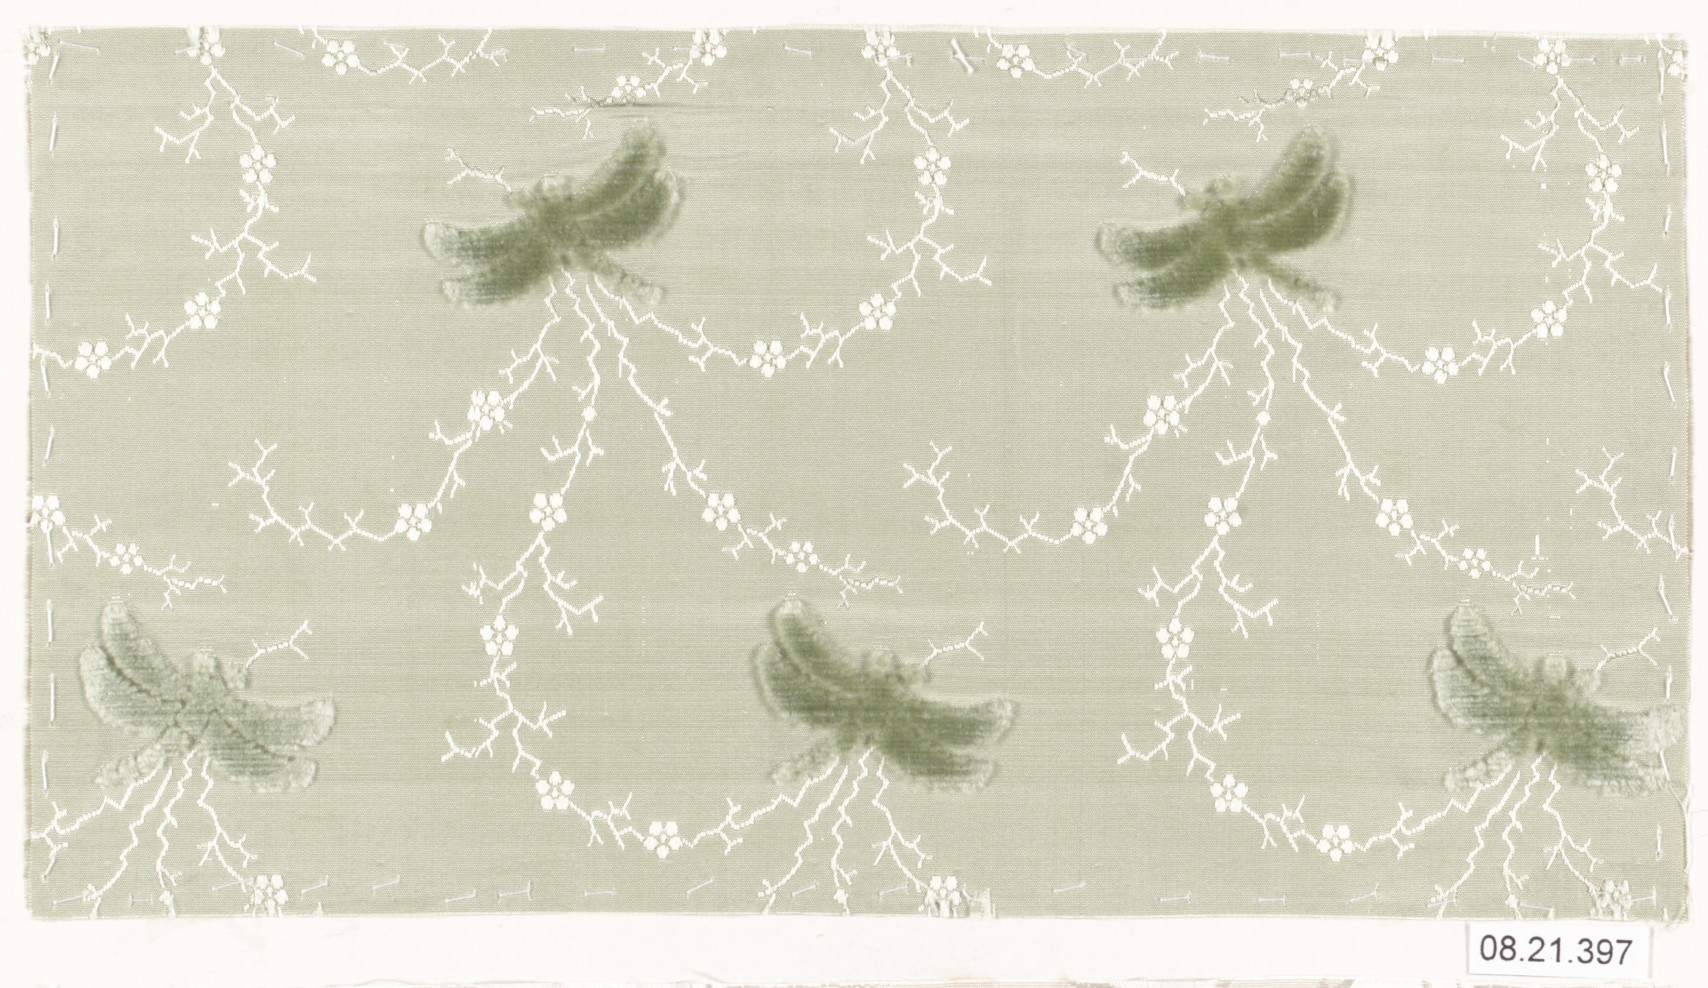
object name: textile sample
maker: Anonymous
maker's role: designer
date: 1900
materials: silk